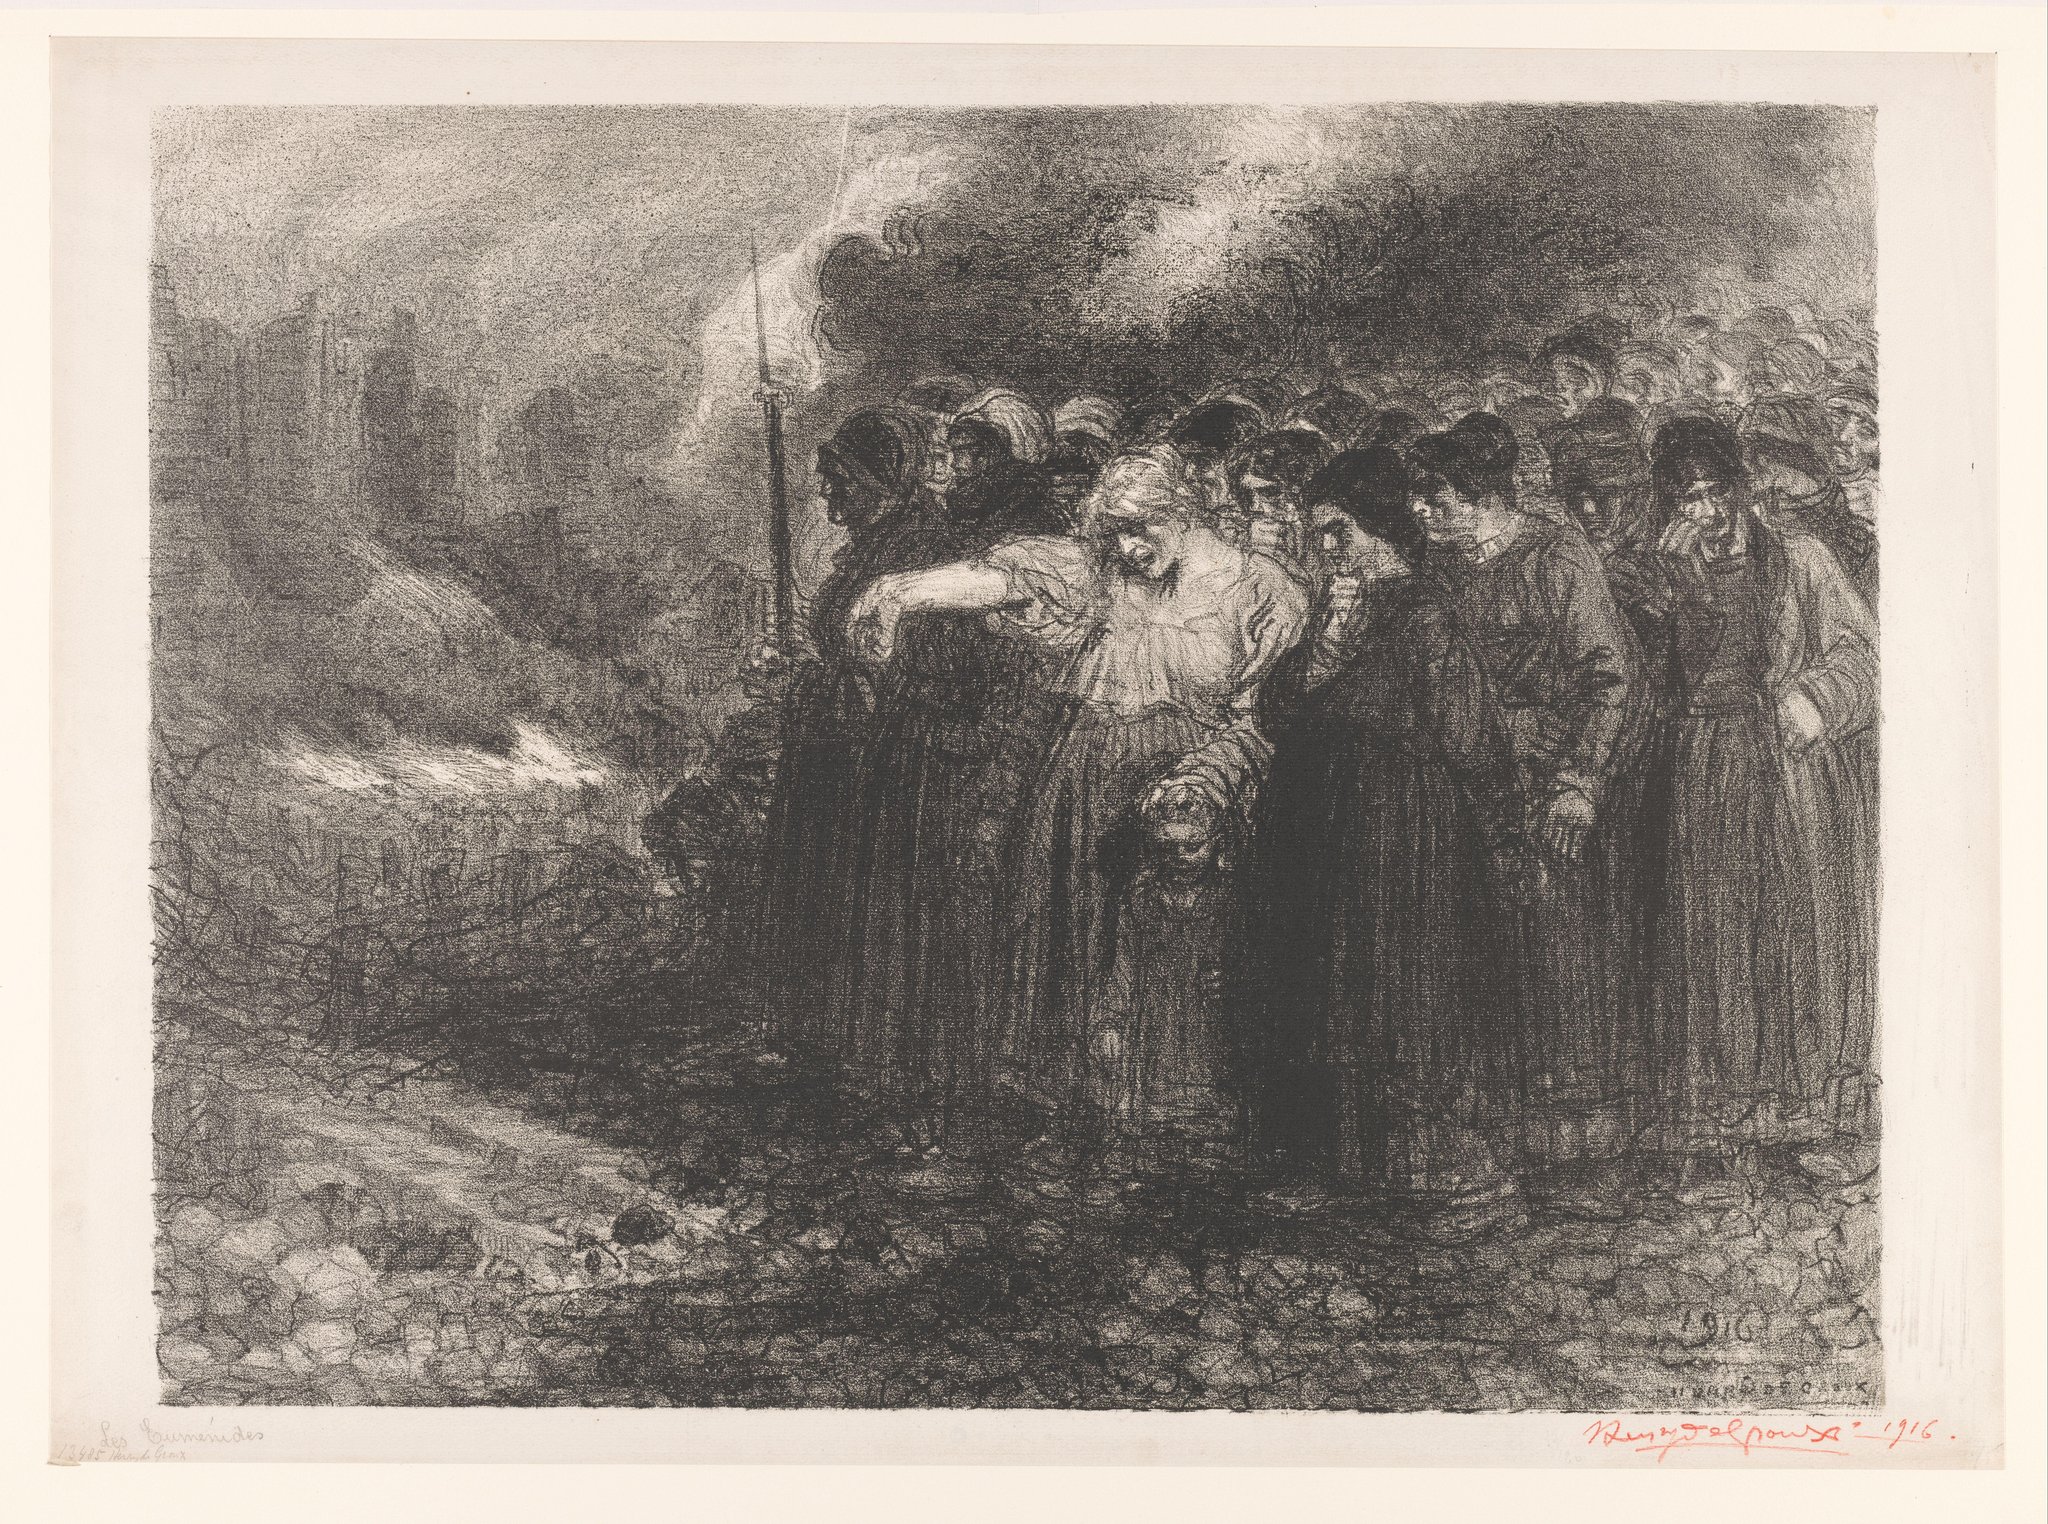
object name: print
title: Menigte aan de rand van een verwoeste stad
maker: henri de groux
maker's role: painter, print maker, sculptor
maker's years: 1866-1930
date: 1916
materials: paper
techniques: lithograph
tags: crowd, mob, ruin of a building ~ architecture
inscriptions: inscription: ‘Les Euménides; 13485 Henry de Groux’, collector's mark: Lugt 2228, collector's mark: Lugt 2760, collector's mark: Lugt 700a